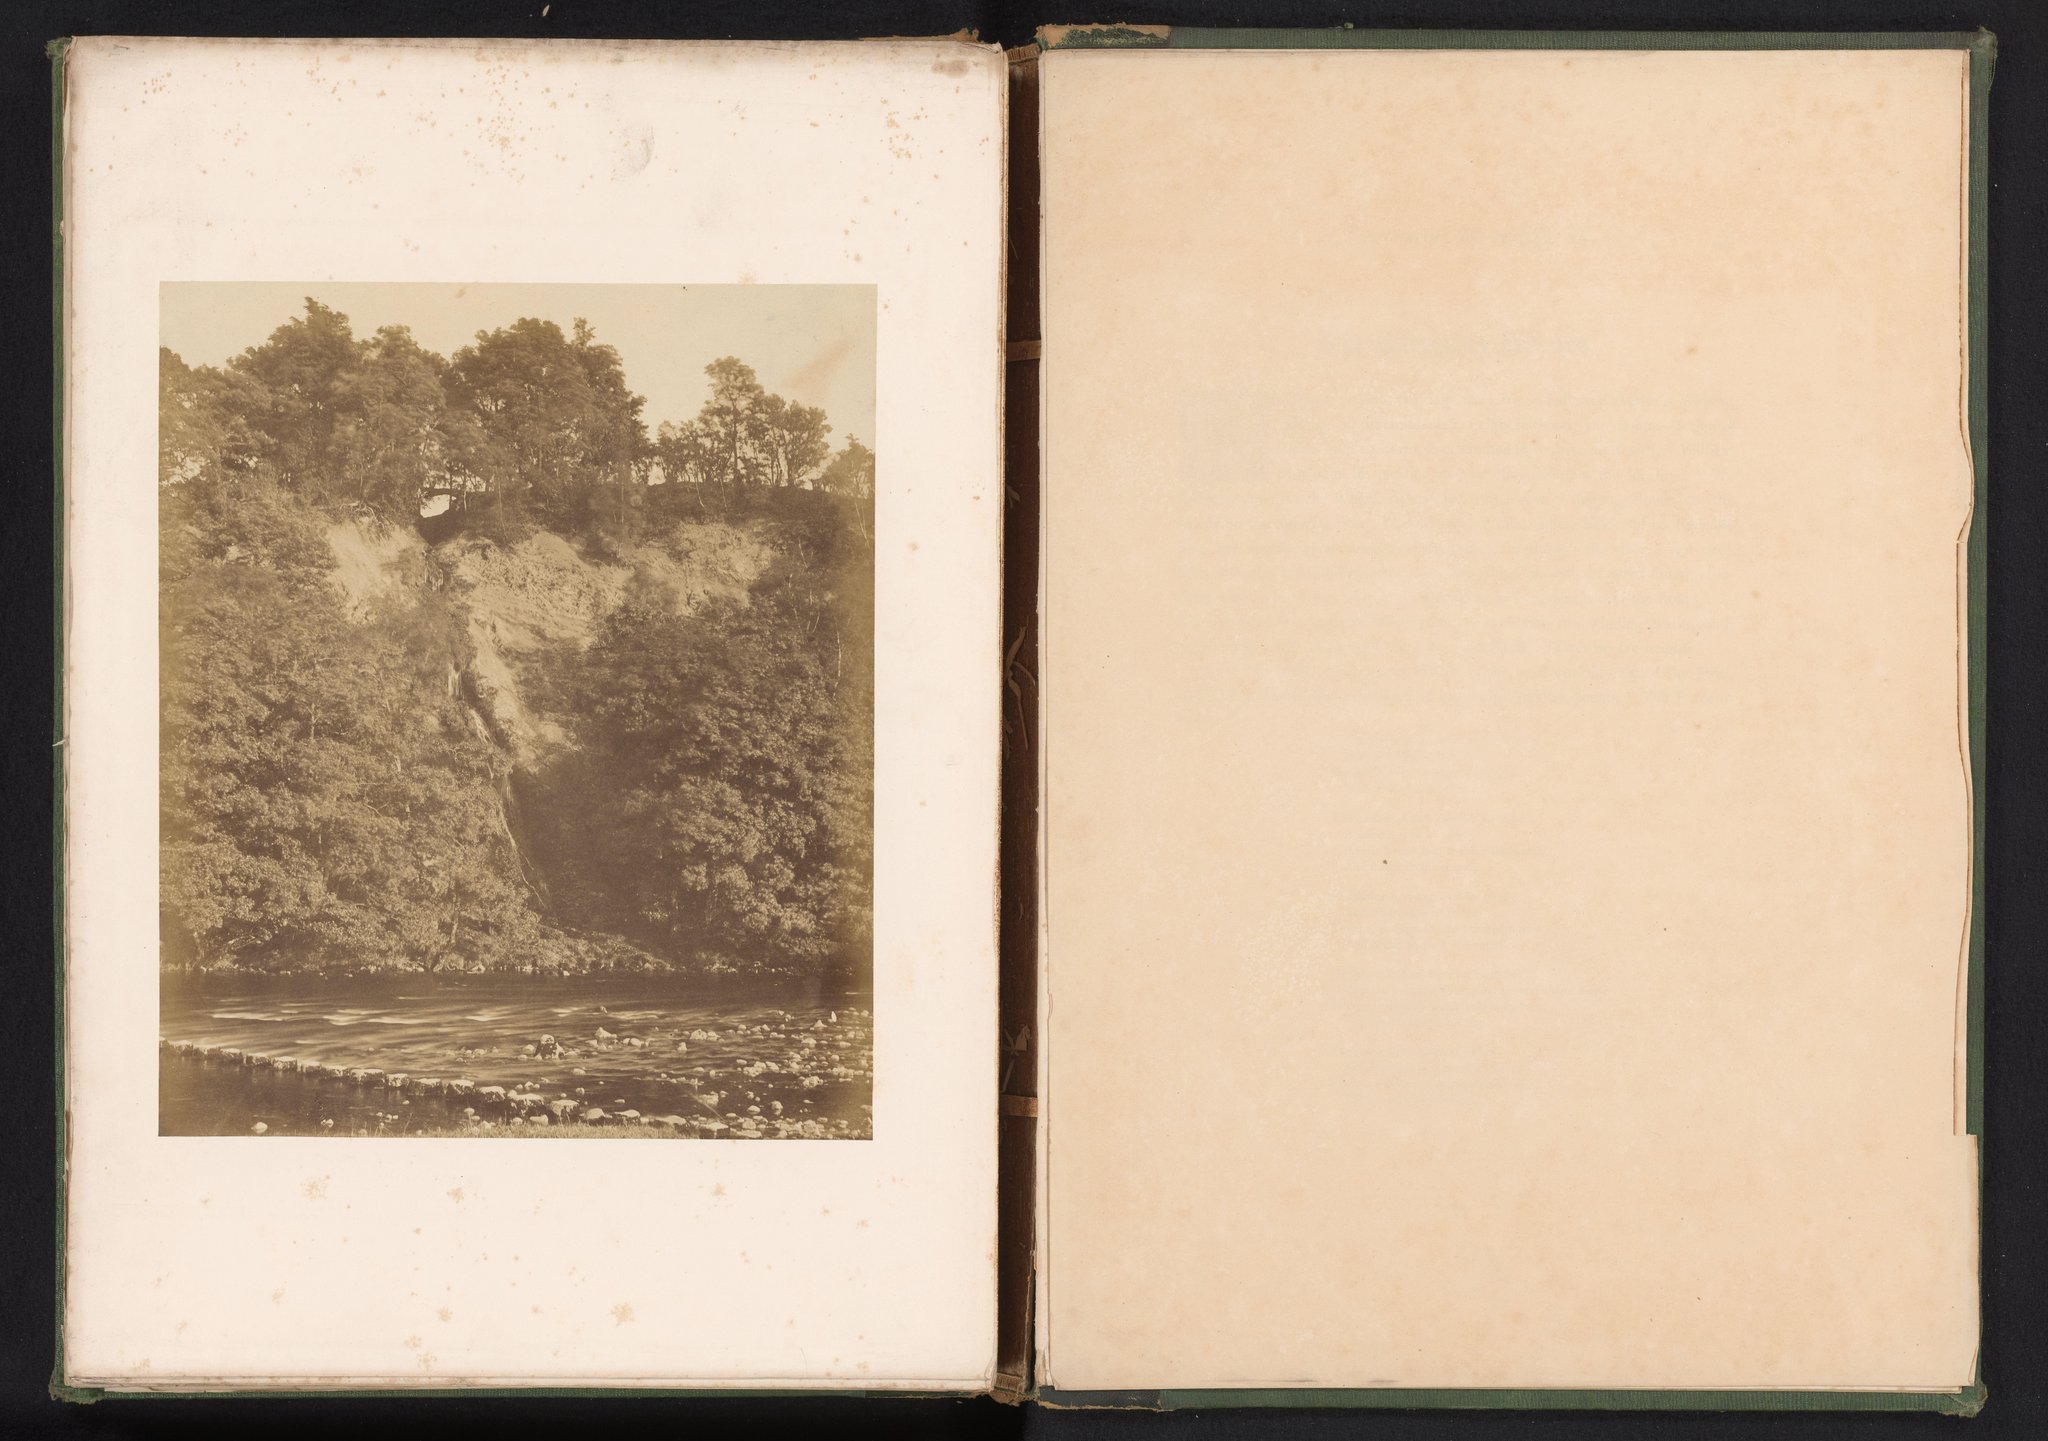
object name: page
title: Gezicht op de Bolton Abbey Stepping Stones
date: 1851-1856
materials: photographic support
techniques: albumen print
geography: bolton abbey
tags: stepping stones, river